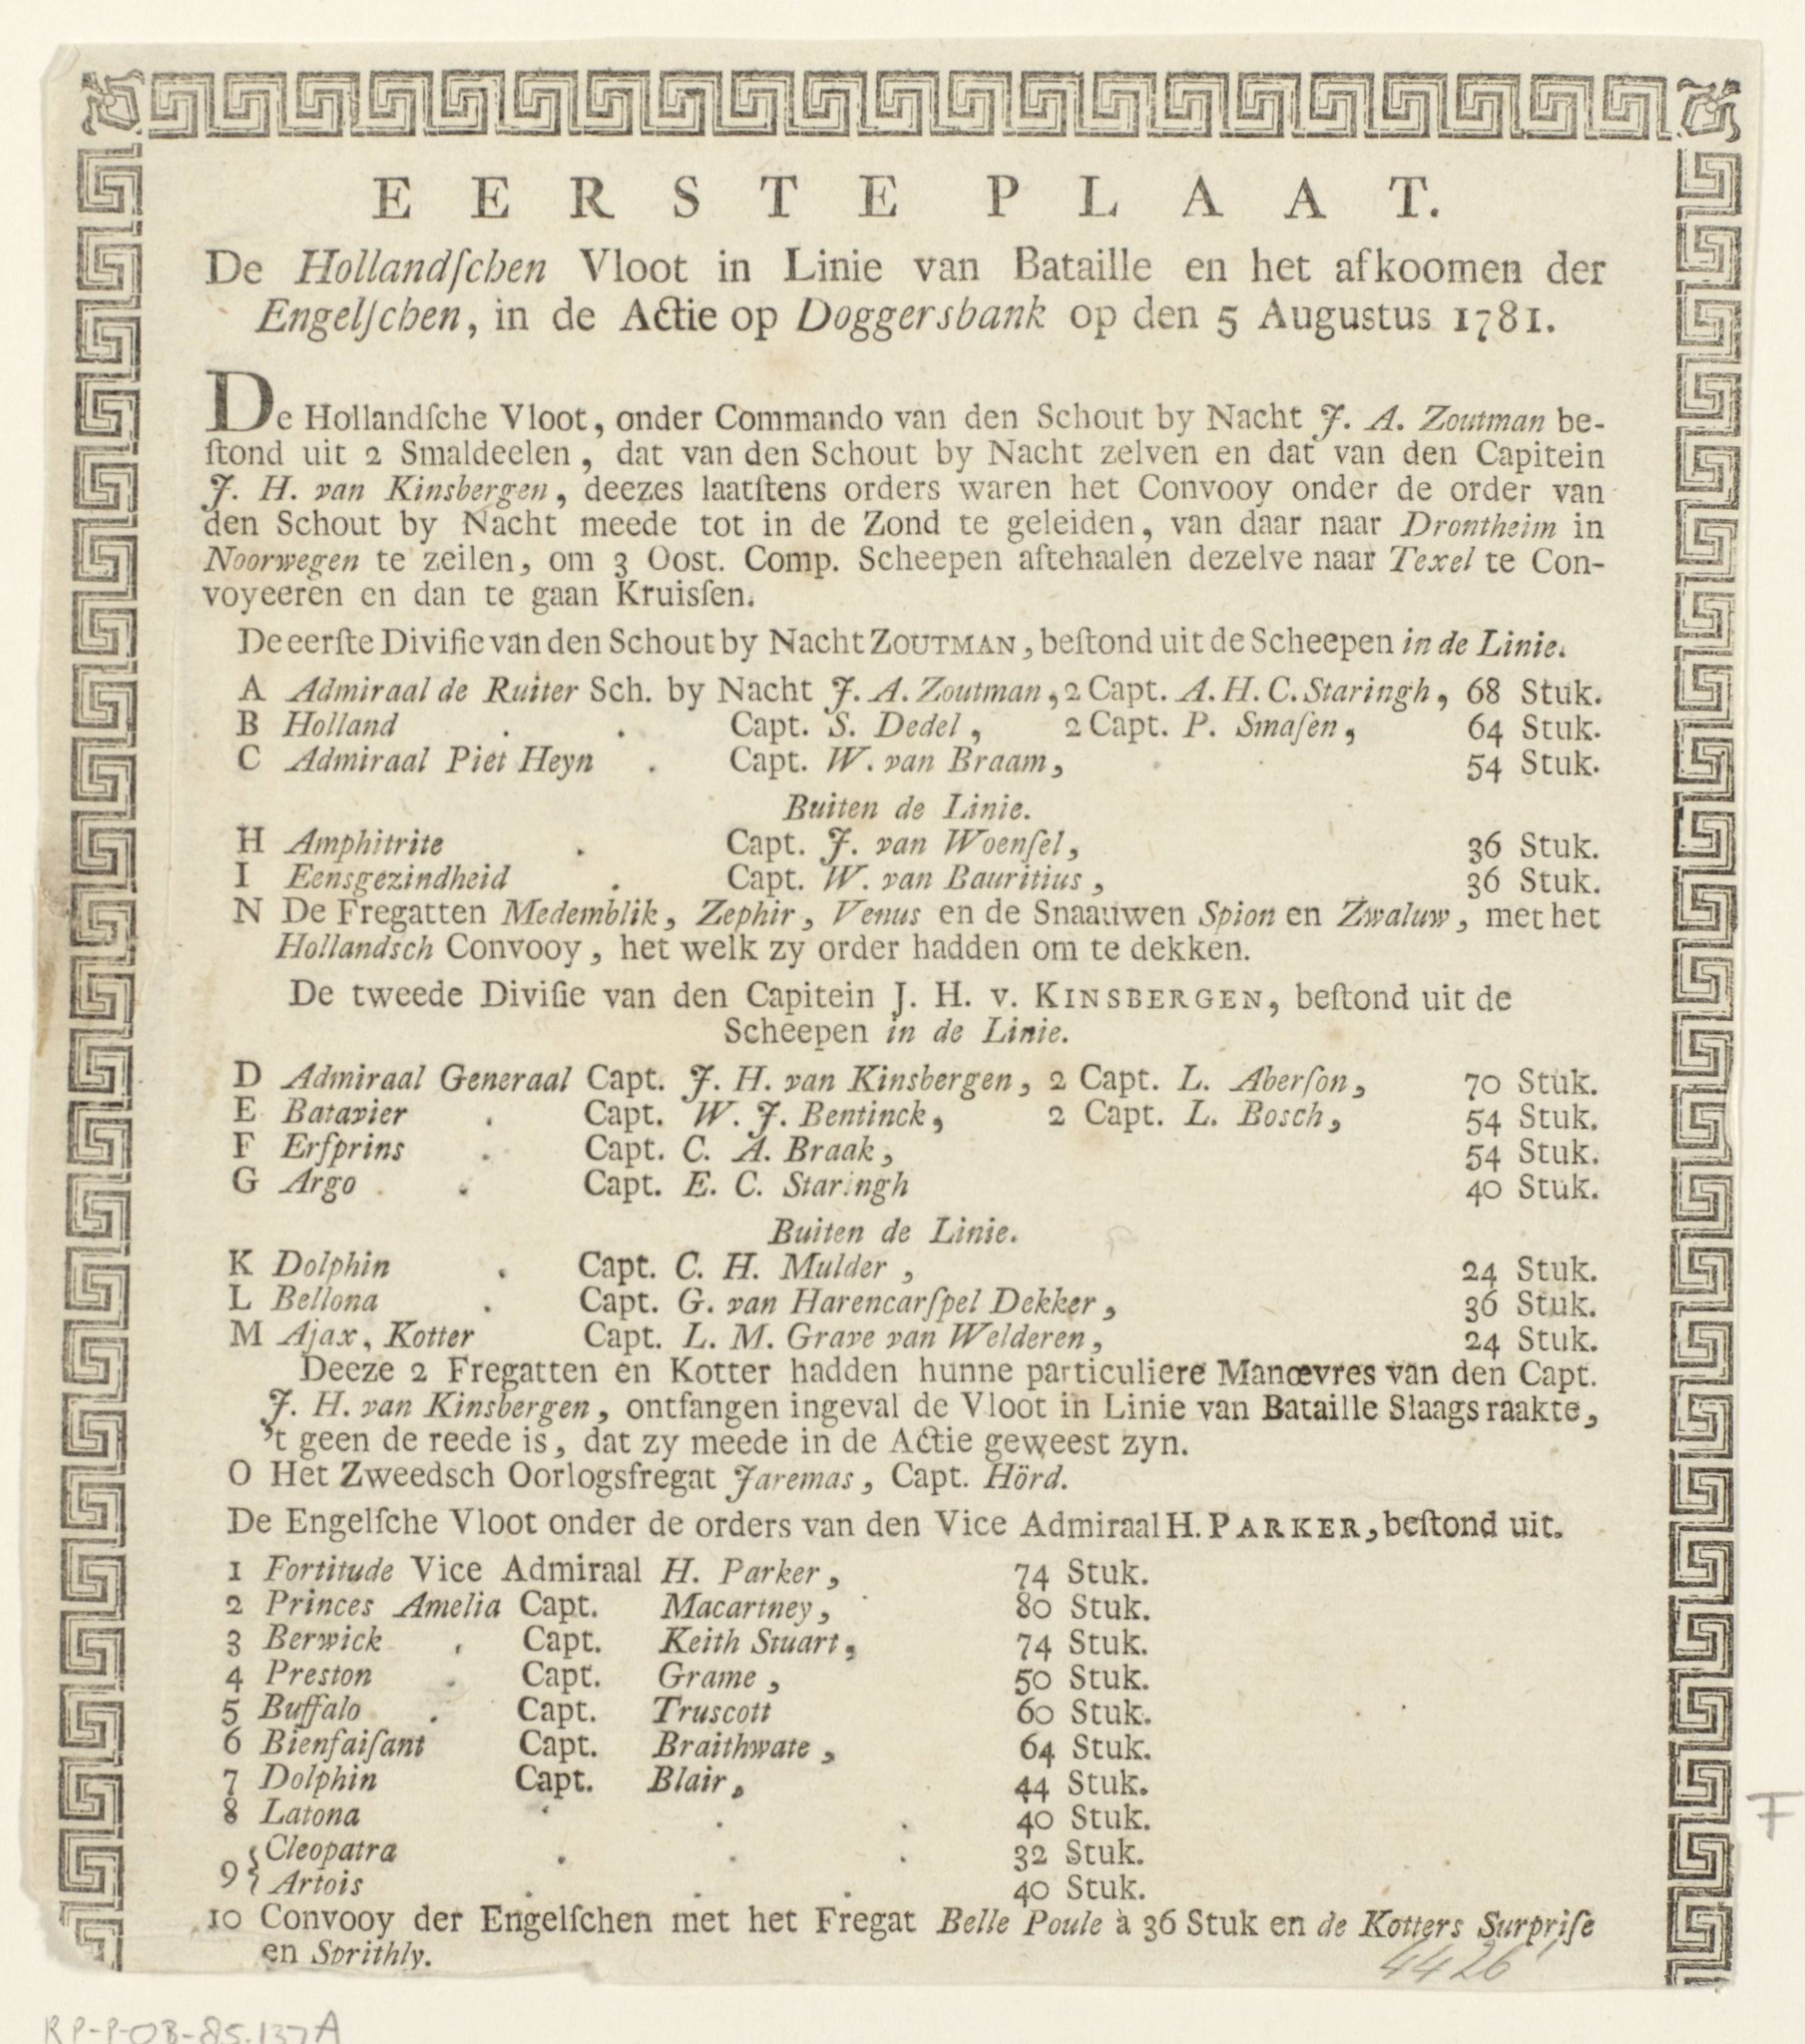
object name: text sheet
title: Eerste Plaat. De Hollandschen Vloot in Linie van Bataille en het afkoomen der Engelschen, in de Actie op Doggersbank op den 5 Augustus 1781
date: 1781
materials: paper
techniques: letterpress printing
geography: amsterdam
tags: the hague, johan arnold zoutman, hyde parker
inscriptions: collector's mark: Lugt 2228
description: Tekstblad bij de prent van de Nederlandse en Engelse schepen in linie bij de aanvang van de zeeslag bij Doggersbank op 5 augustus 1781 tussen de Nederlandse vloot onder schout-bij-nacht Johan Zoutman en de Engelse vloot onder vice-admiraal Hyde Parker. Onderdeel van een serie van drie platen van de Zeeslag op de Doggersbank. Los uitgeknipt tekstblad met een uitleg van de plaat en een overzicht van de schepen met hun kapiteins en de aantallen stukken.